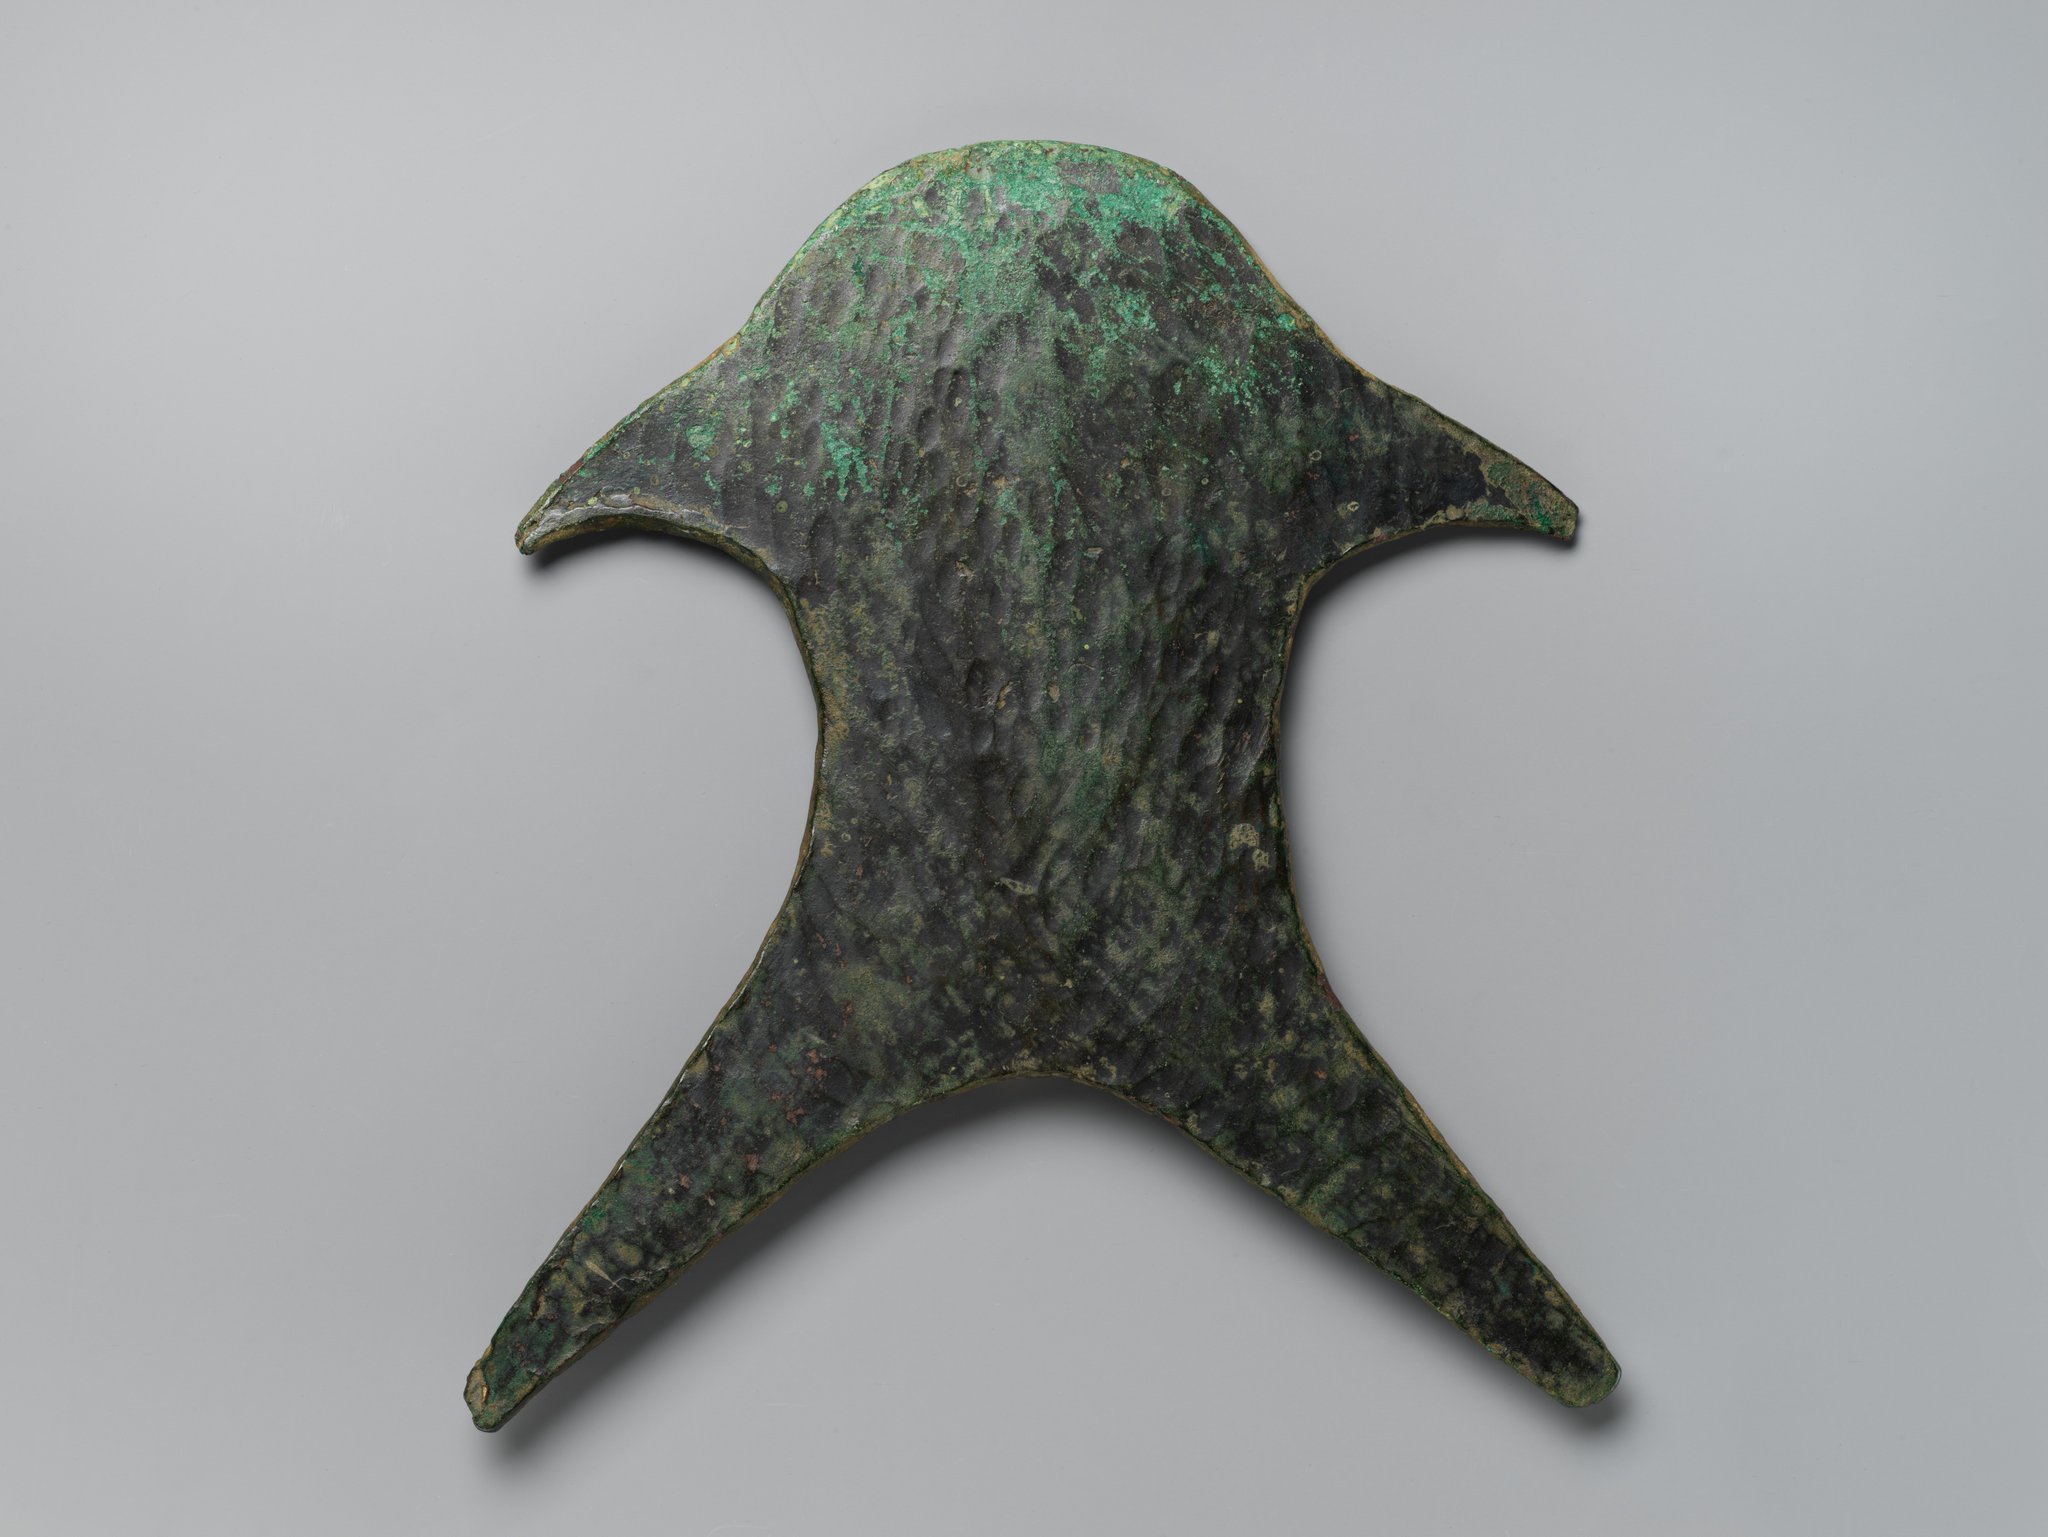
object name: anthropomorph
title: Eccentric Anthropomorph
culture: indian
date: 1500-1000 BCE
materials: copper